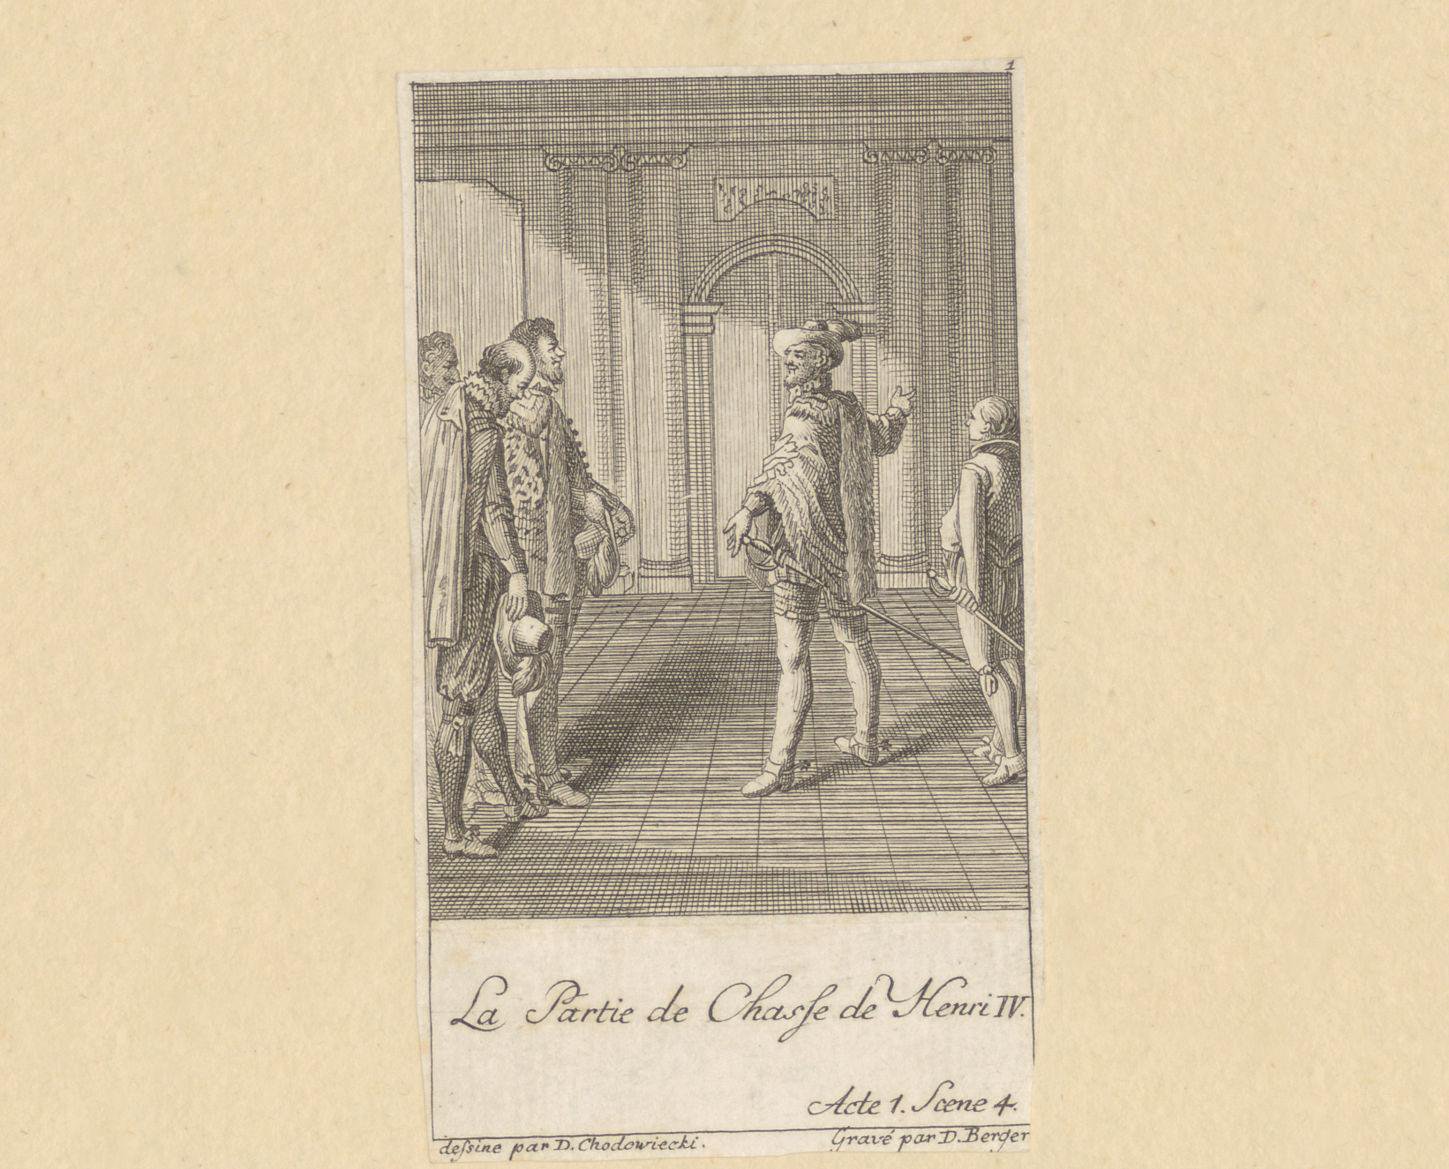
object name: print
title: Hendrik IV in jachtkostuum met edelen in een hal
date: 1774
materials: paper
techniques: etching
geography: berlin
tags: paris, hendrik iv (koning van frankrijk en navarra), literary characters and objects, assembling, 'départ pour la chasse'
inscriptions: collector's mark: Lugt 2228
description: Prent afkomstig uit: Almanac généalogique: pour l'année 1785, uitgegeven te Berlijn. Deze prent maakt deel uit van een serie van twaalf prenten, gedrukt van een koperplaat. De prenten tonen scènes uit het toneelstuk 'La partie de chasse de Henri IV' (1767) van Charles Collé. Deze serie verscheen eerder met Duitse onderschriften in: Genealogischen Calender für West-Preussen auf das Jahr 1775, uitgegeven op kosten van de Konigliche Academie der Wissenschaften.